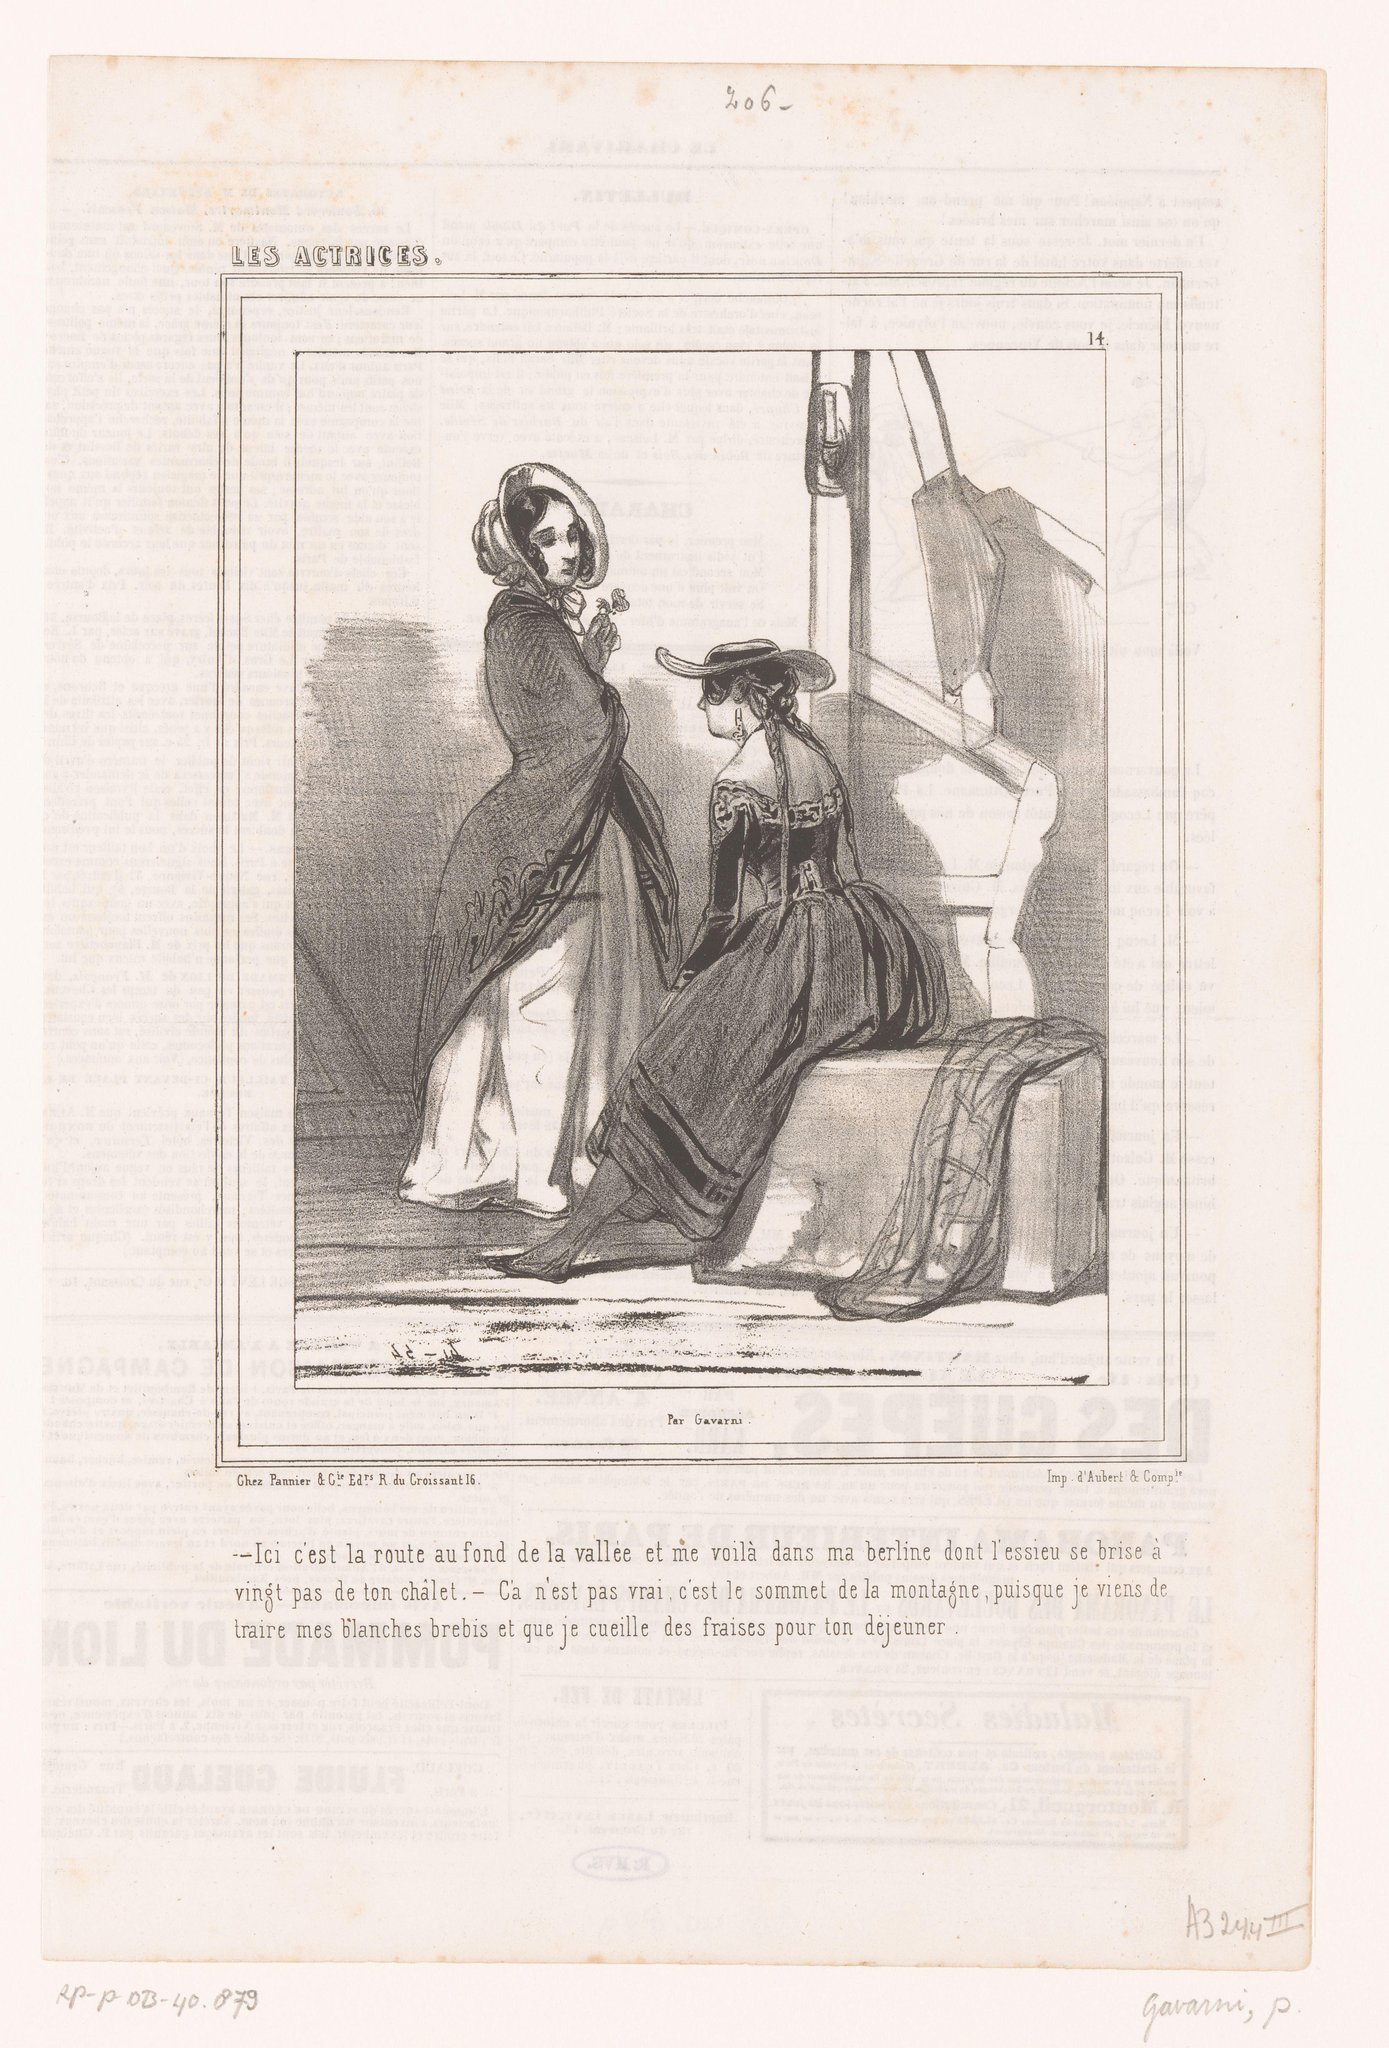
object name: print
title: Toneelspeelsters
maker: paul gavarni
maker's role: draughtsman, print maker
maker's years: 1804-1866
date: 1843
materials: paper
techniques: lithograph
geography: paris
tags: behind the stage, actress (on the stage), stage costume - cc - female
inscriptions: collector's mark: Lugt 2228a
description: Prent gebruikt voor: La Caricature, 4 juli 1841, en voor: Le Charivari, 13 april 1843.